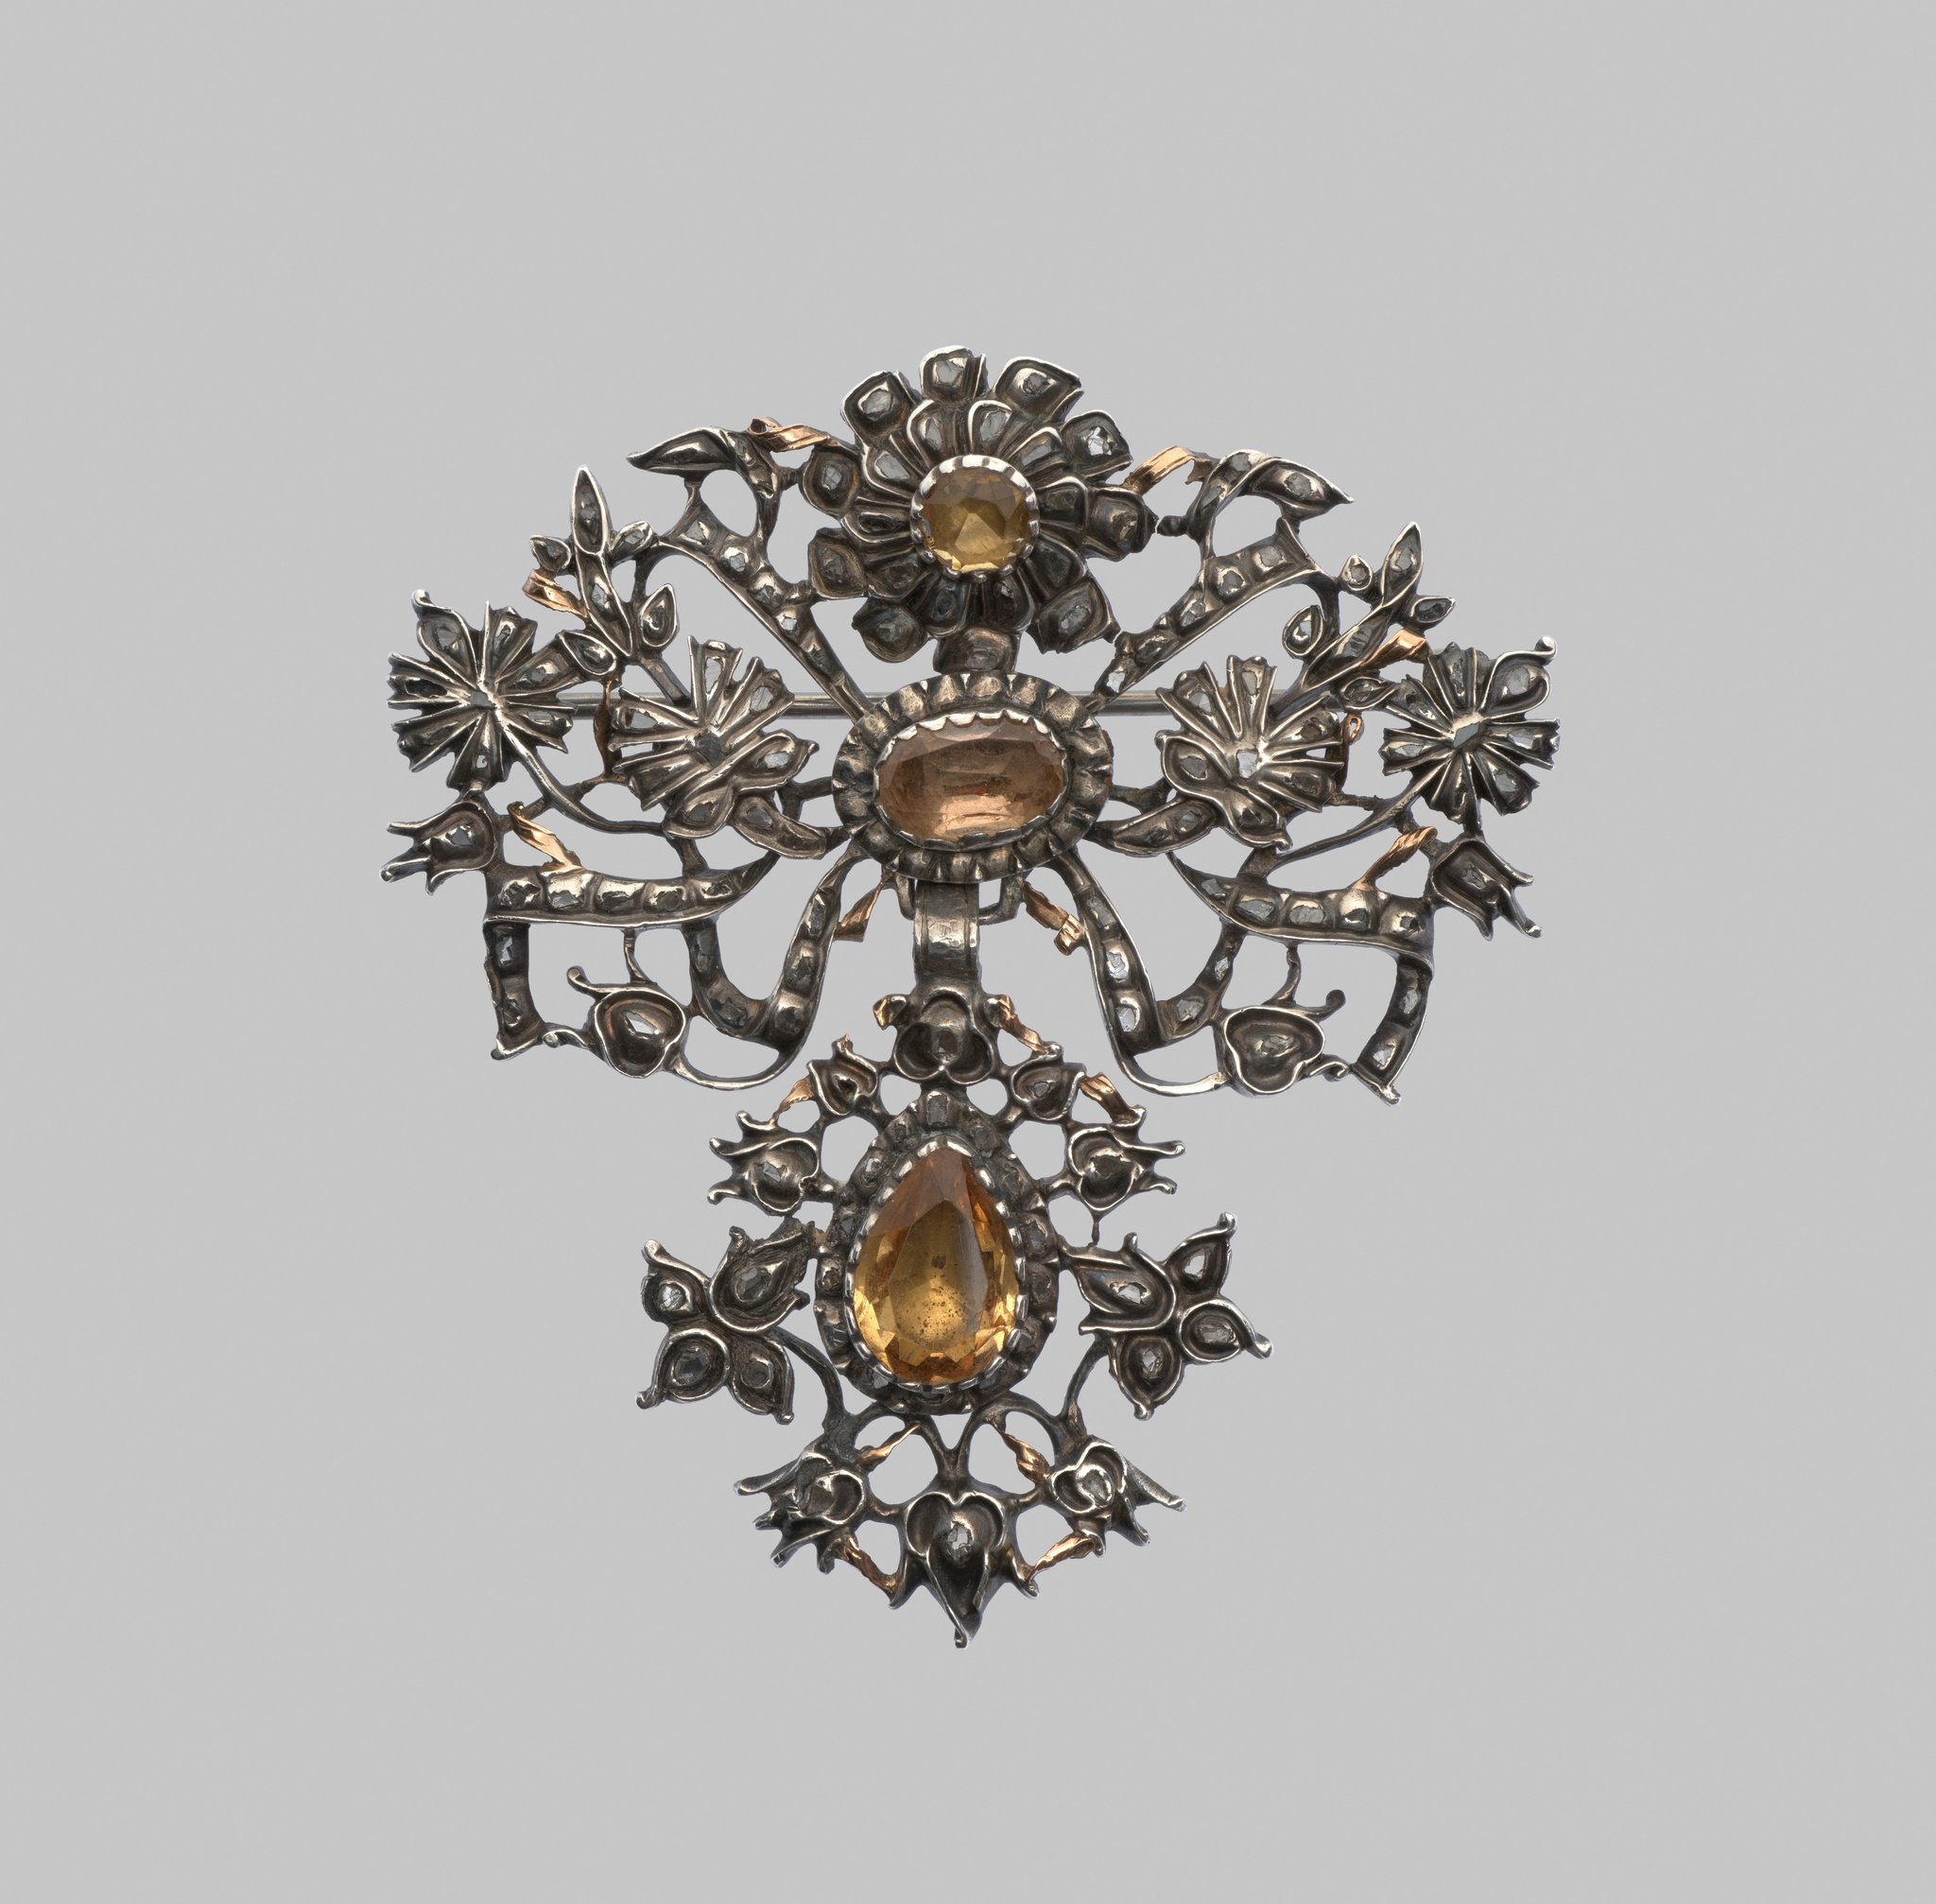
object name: brooch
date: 1701-1800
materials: diamond, silver, silver gilt, gemstone